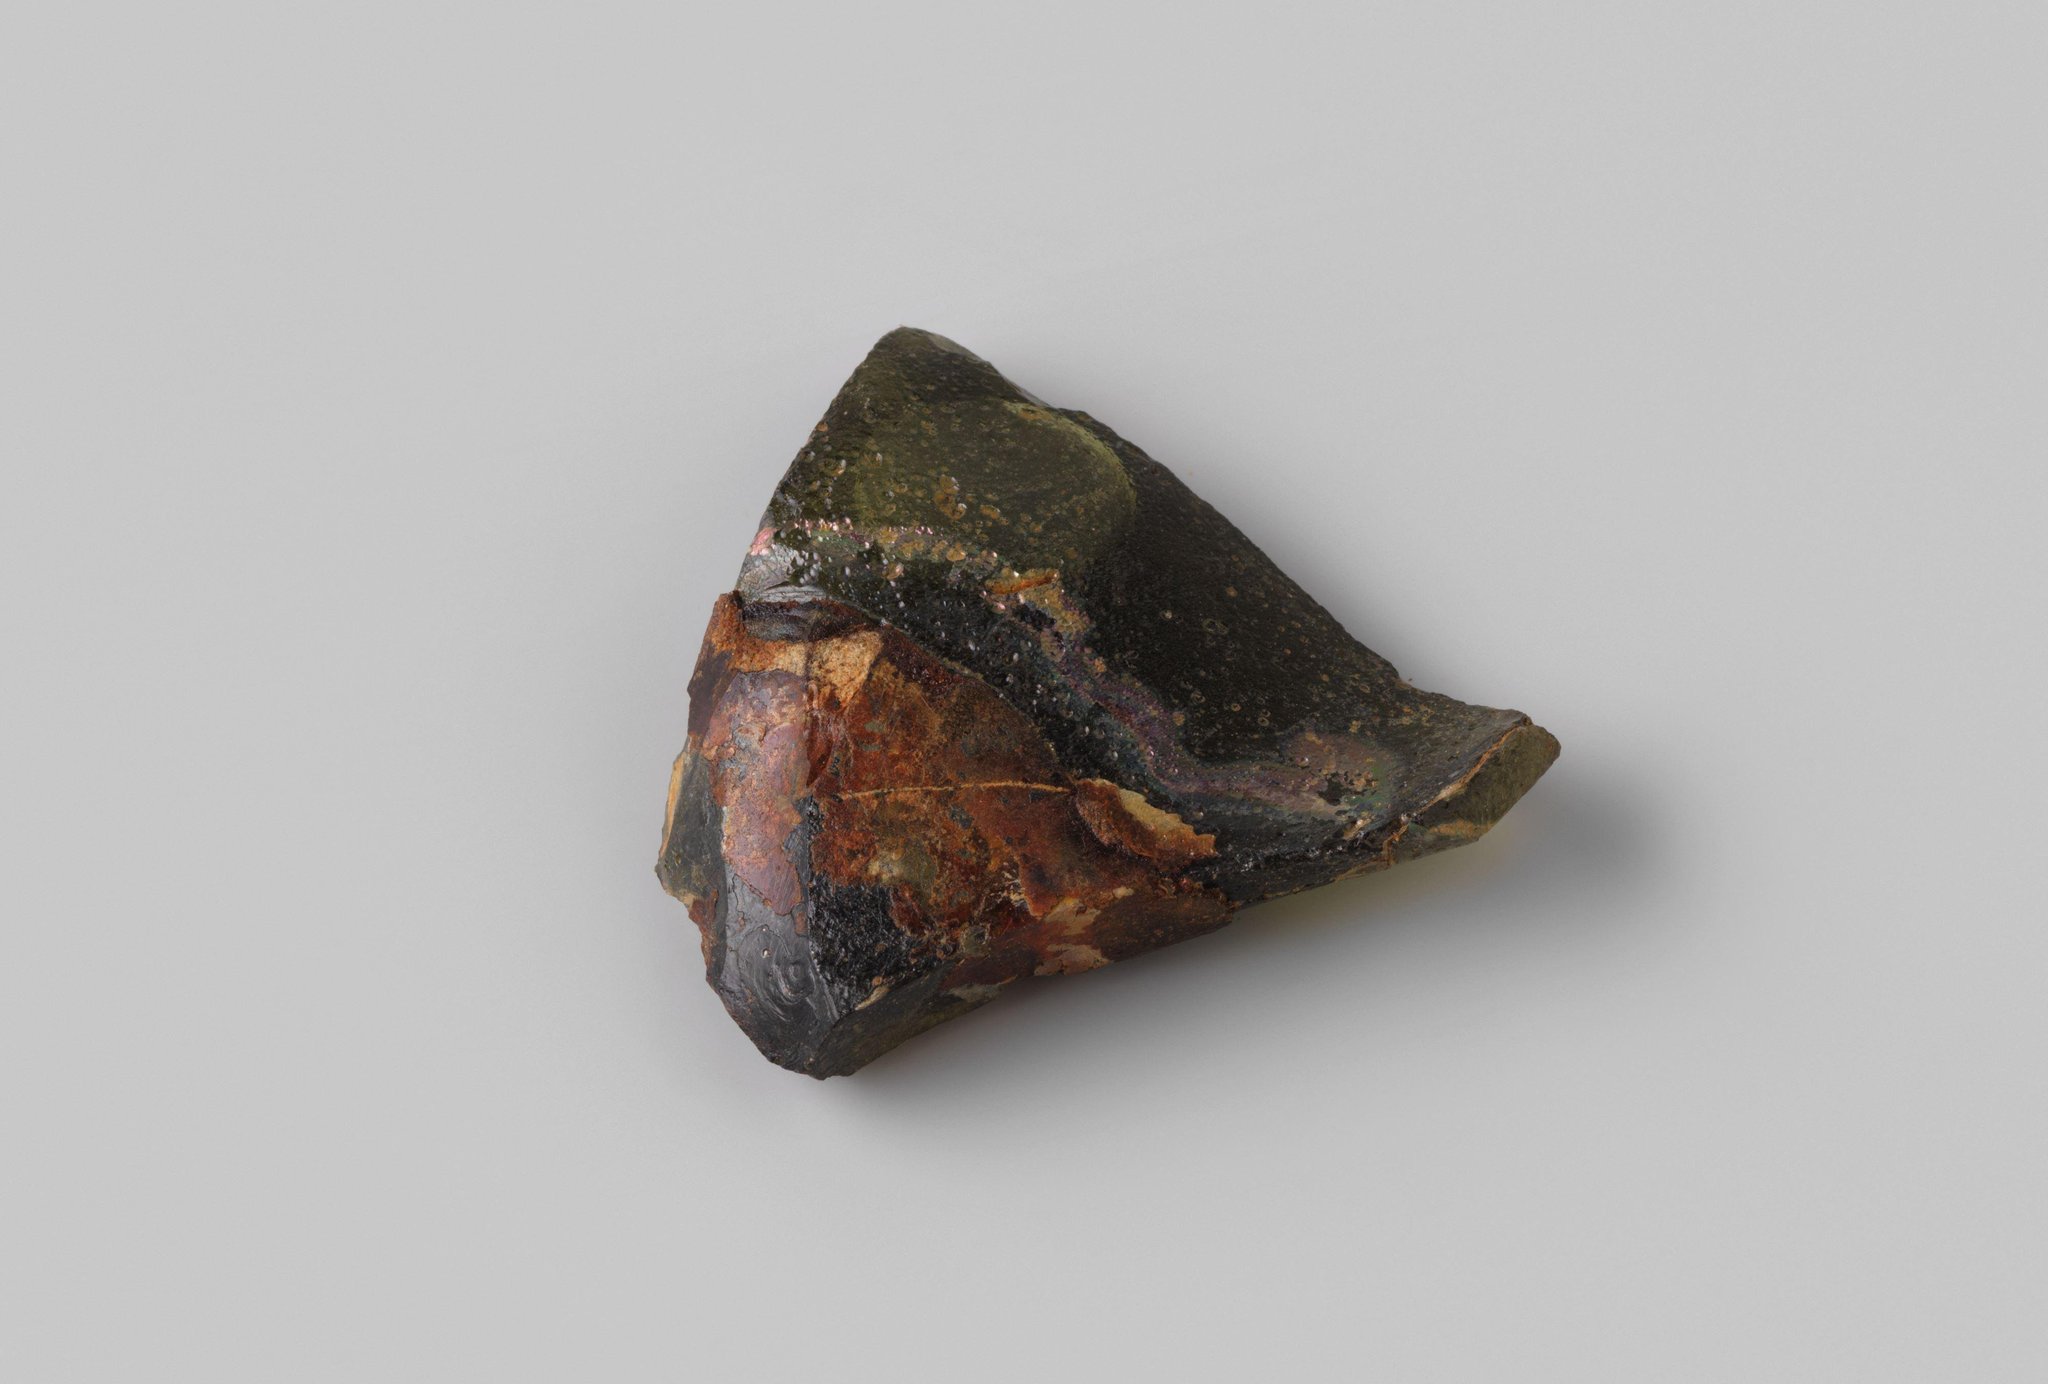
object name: sherd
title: Scherf van een wijnfles uit het wrak van de Oost-Indiëvaarder Hollandia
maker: Anonymous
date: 1700-1743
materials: glass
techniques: green glass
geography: netherlands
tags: verenigde oostindische compagnie, hollandia (schip), annet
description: Typologically not identifiable, base, fragm.